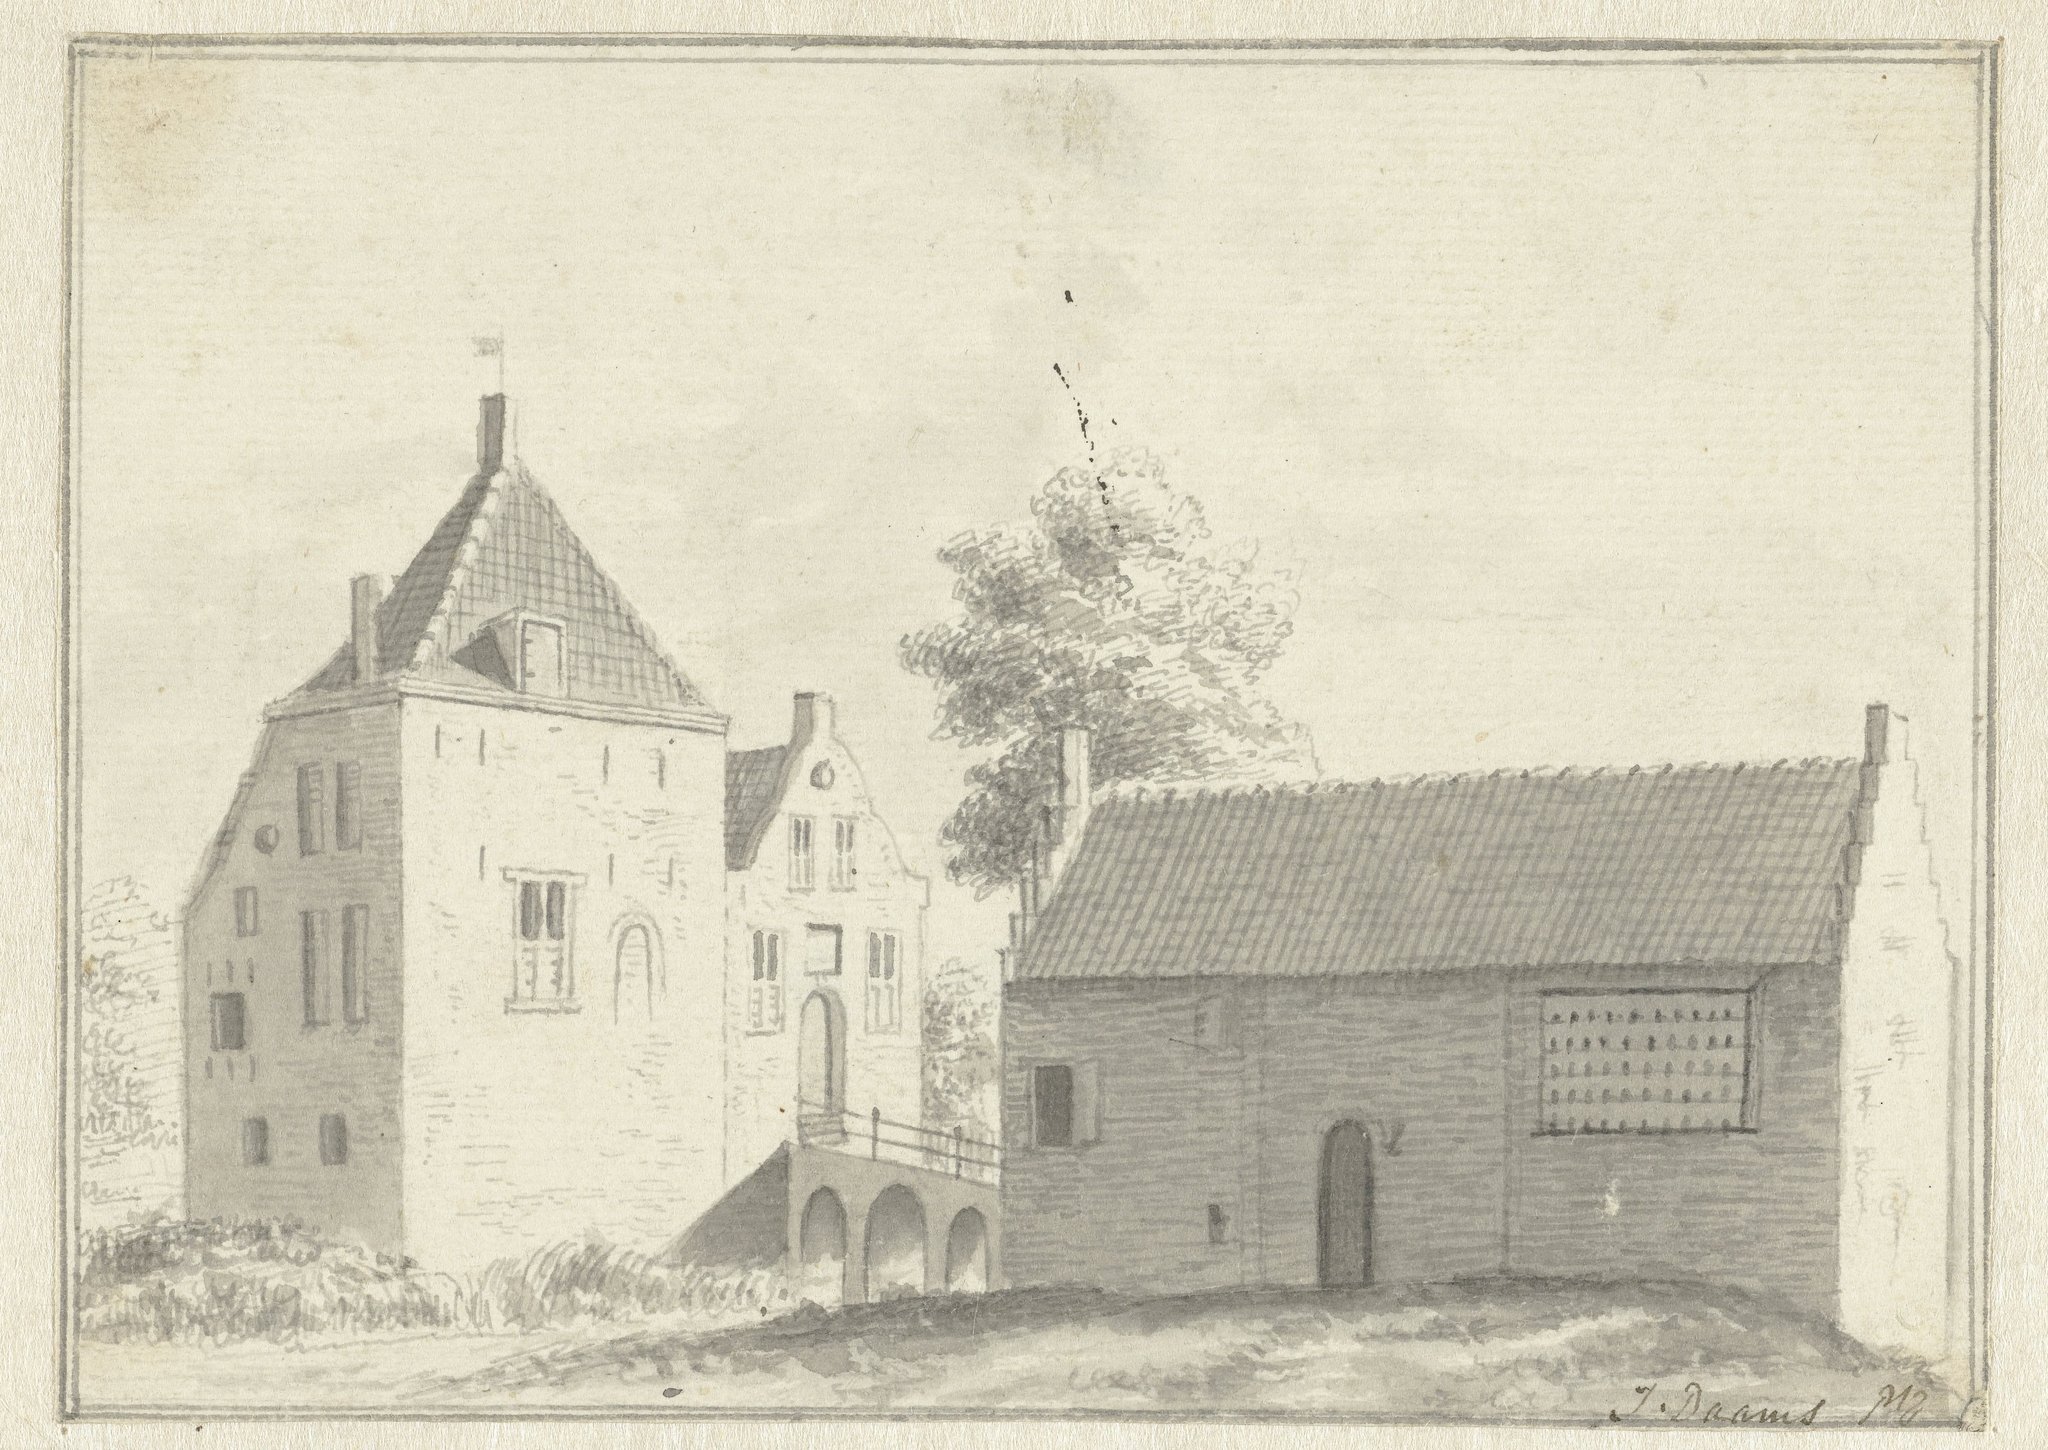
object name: drawing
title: Kasteel Hinderstein te Langbroek vanuit het westen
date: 1700-1800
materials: ink, paper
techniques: brush, pen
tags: castle